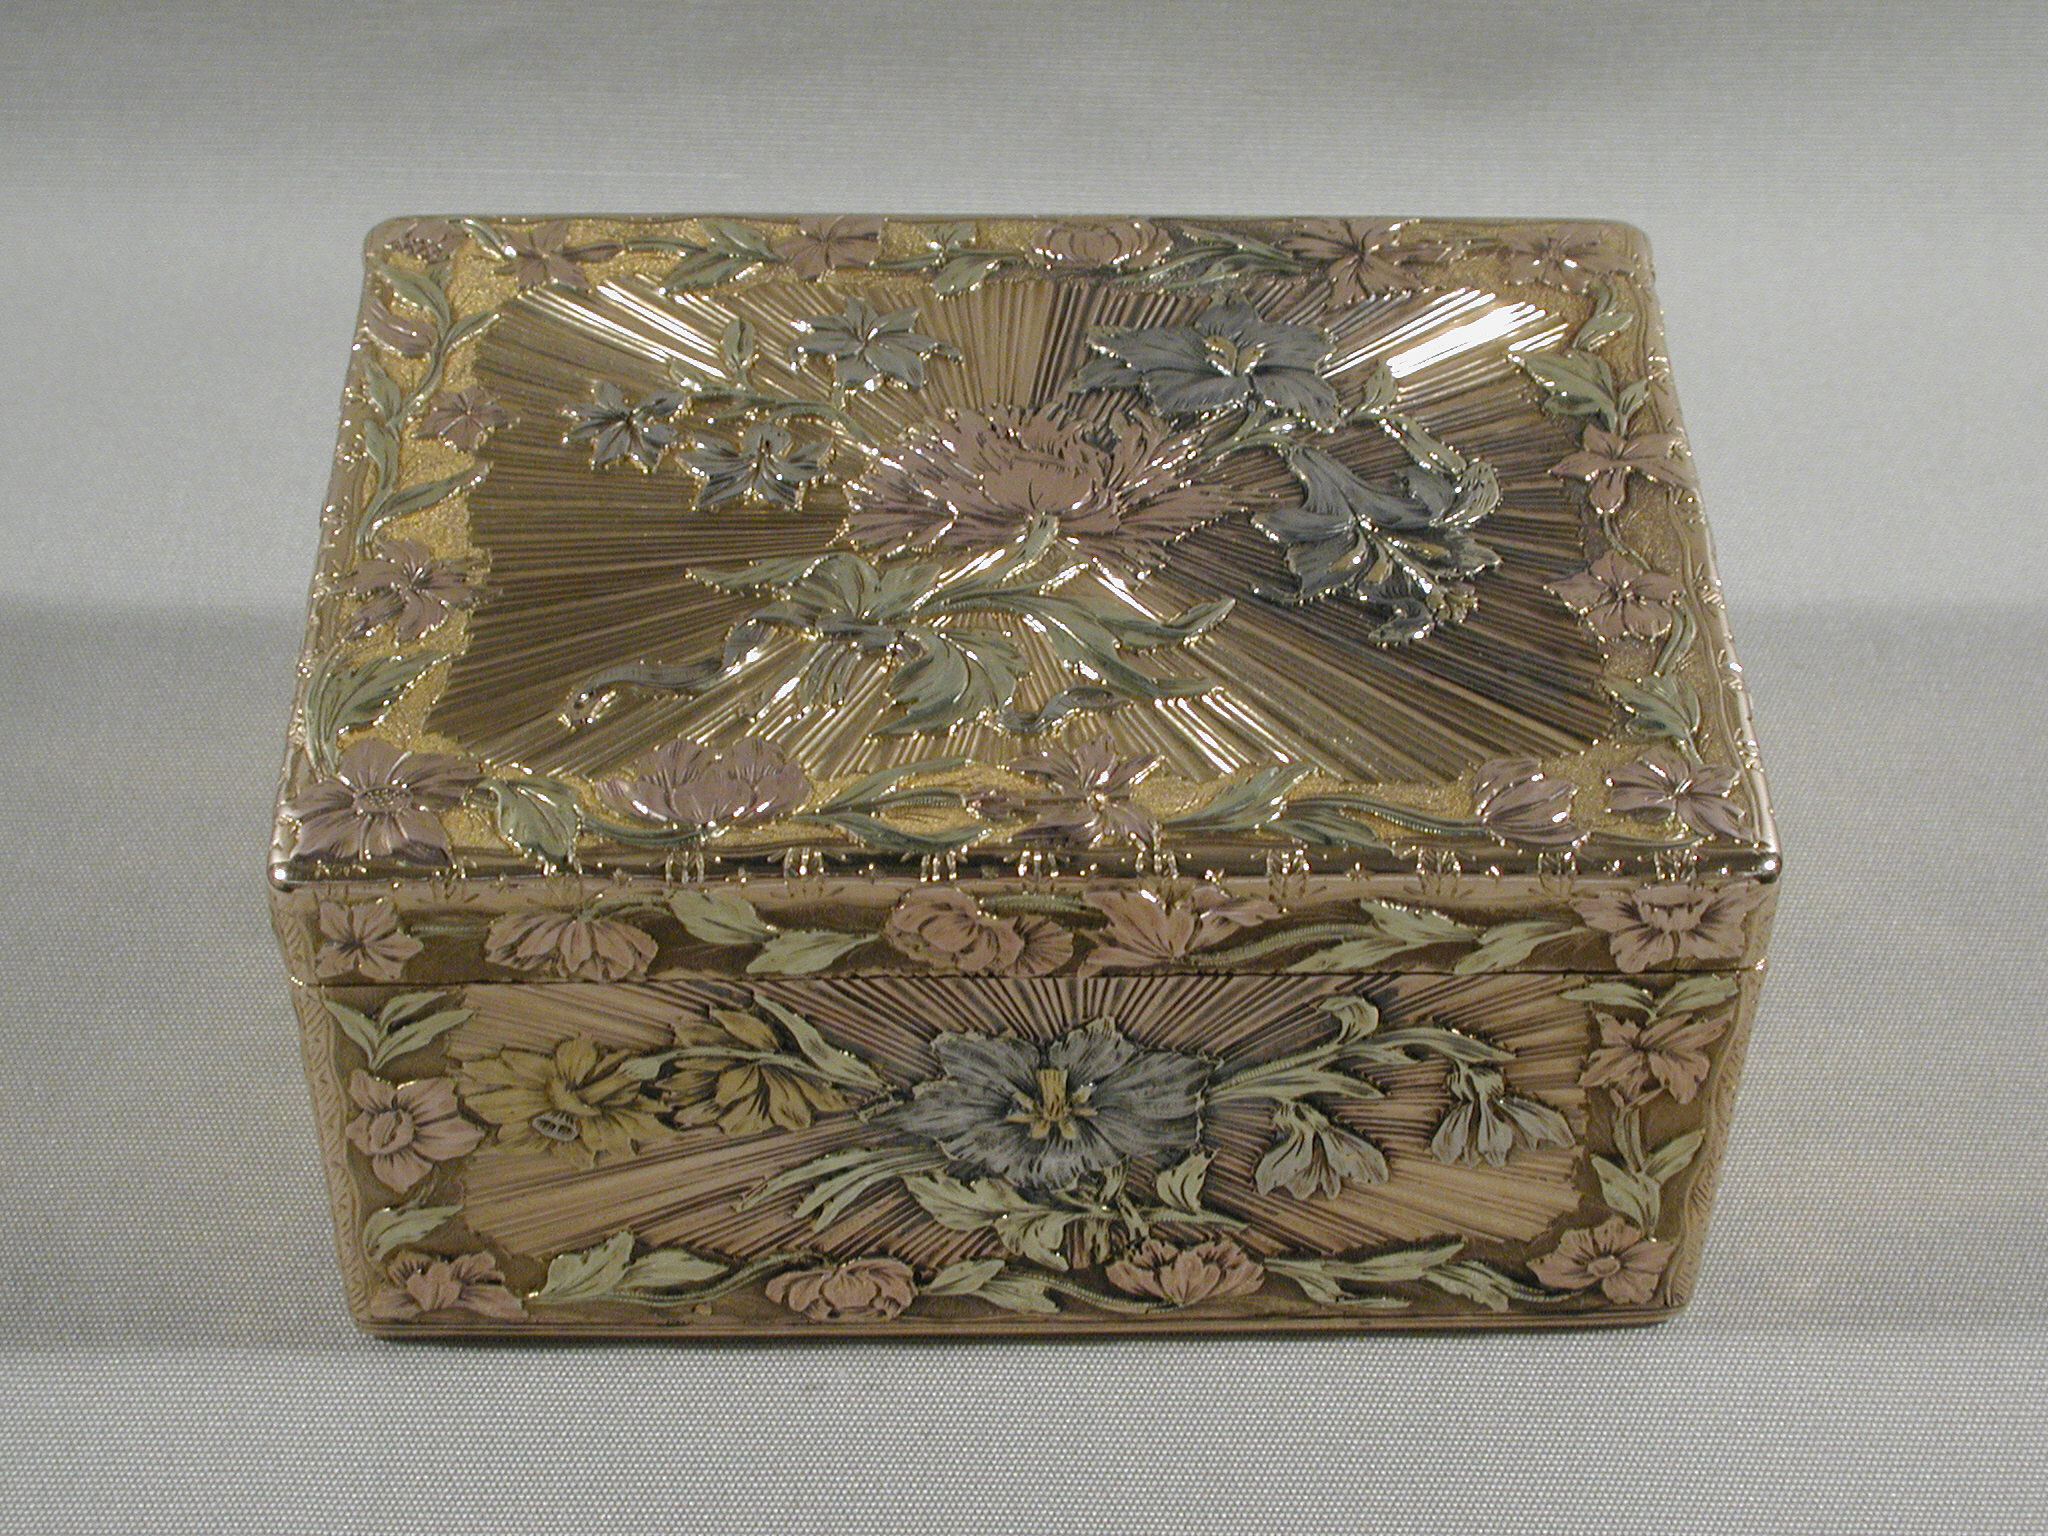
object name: snuffbox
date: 1754-1755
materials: gold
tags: flowers